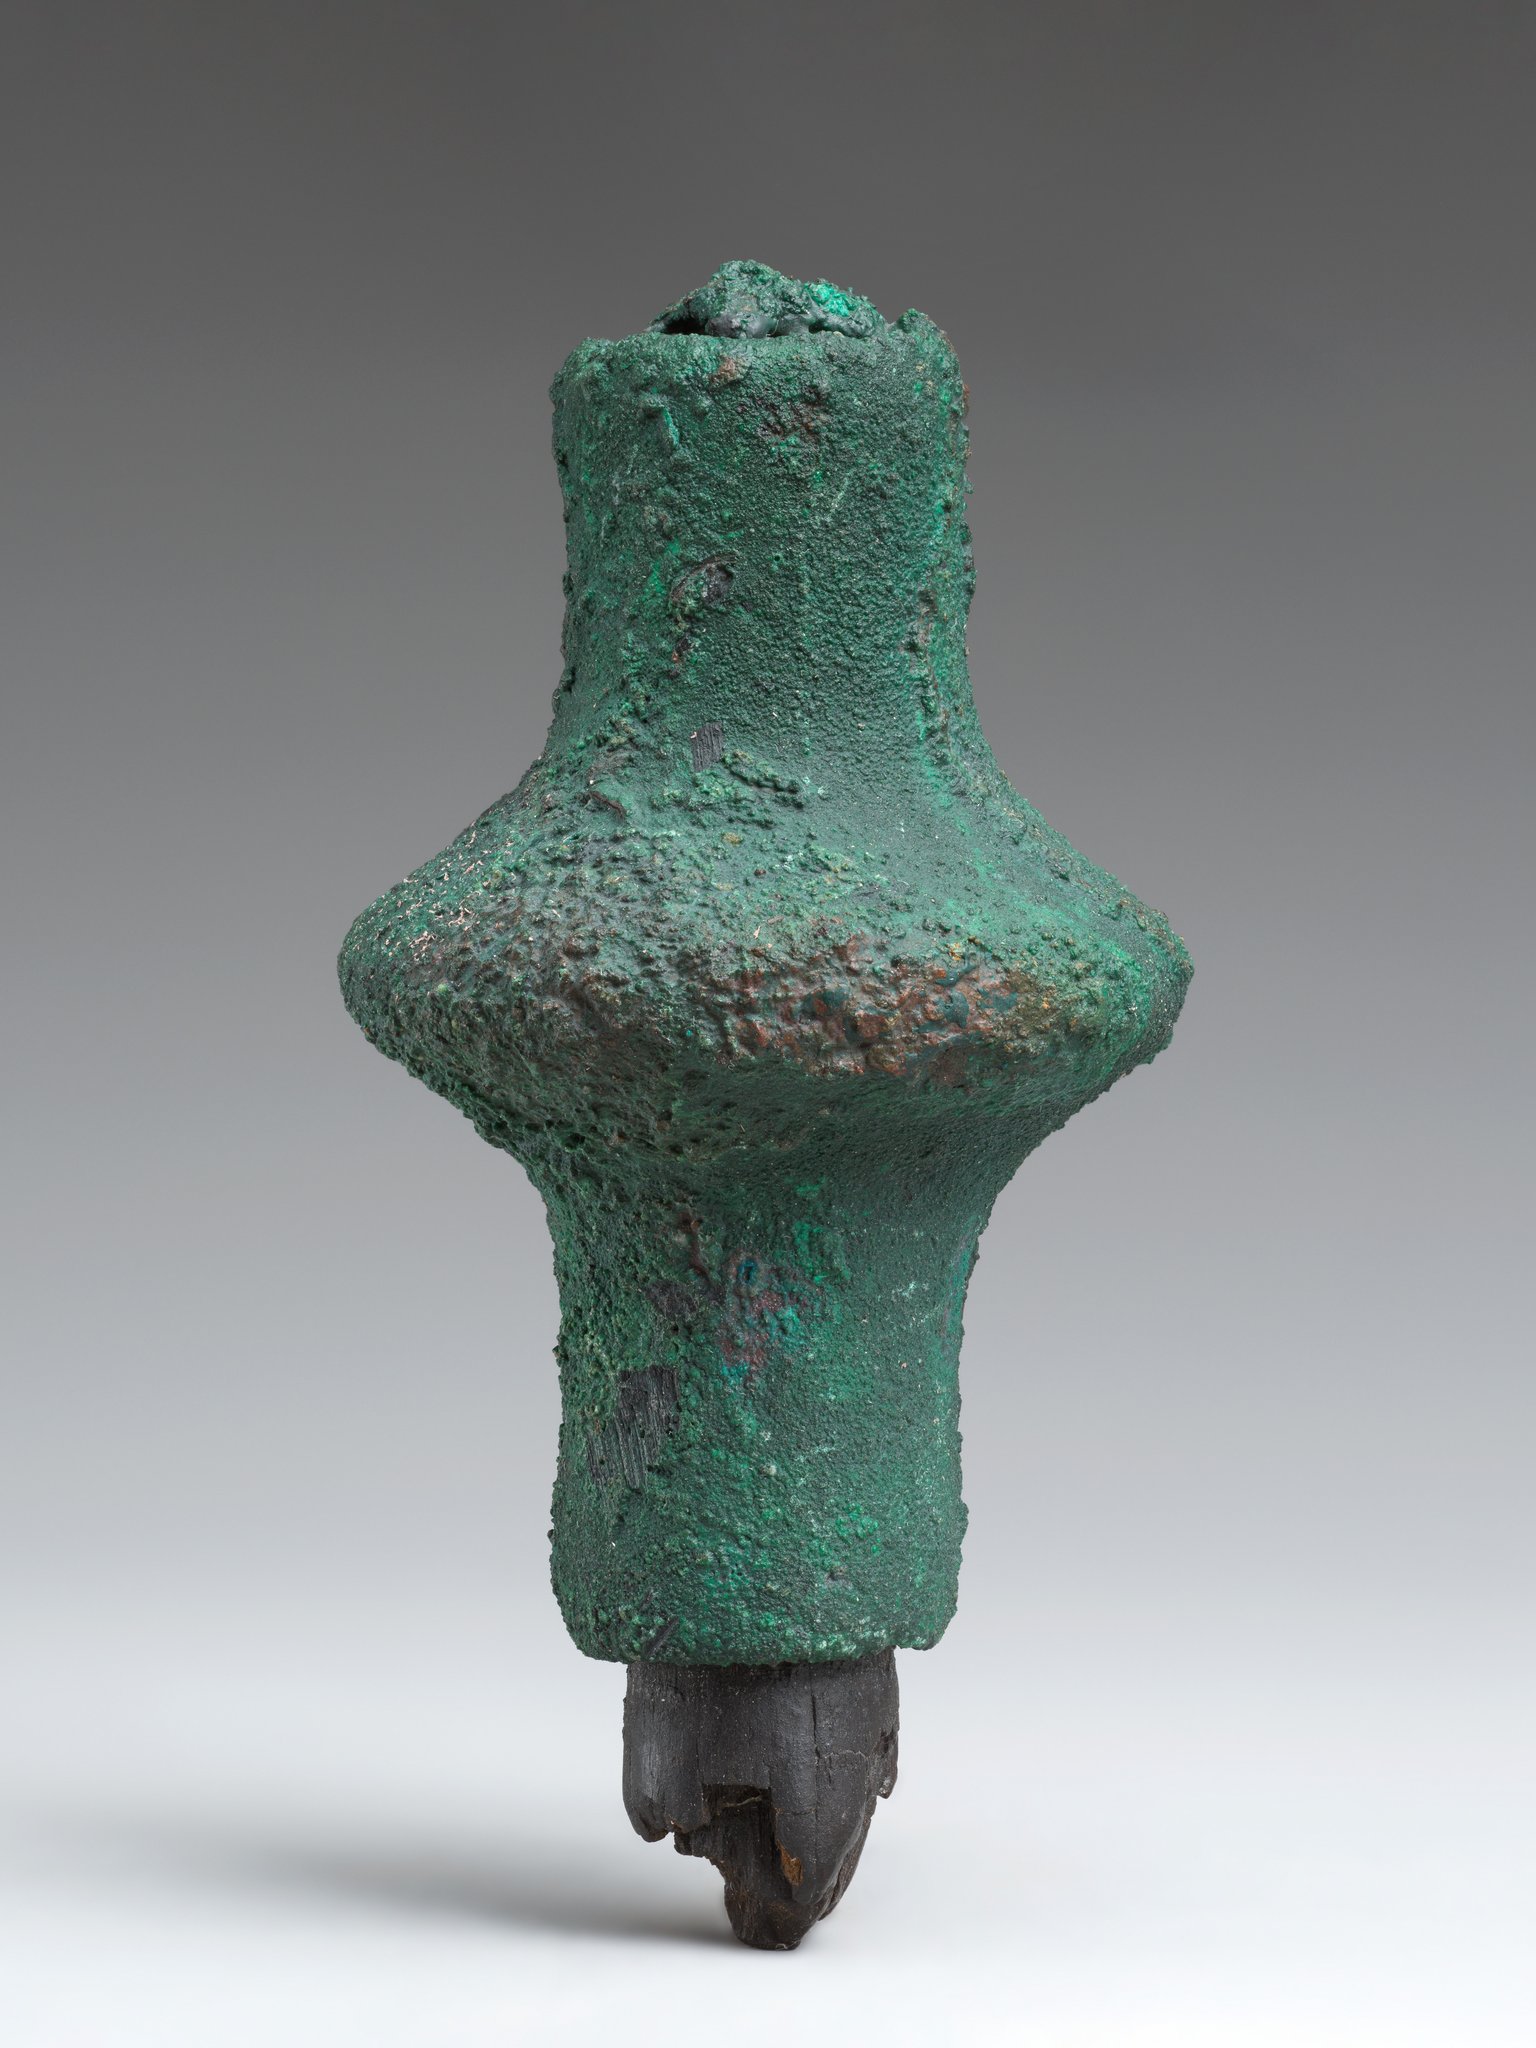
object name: mace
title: Mace head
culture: iranian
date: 900-801 BCE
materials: bronze, copper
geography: iran